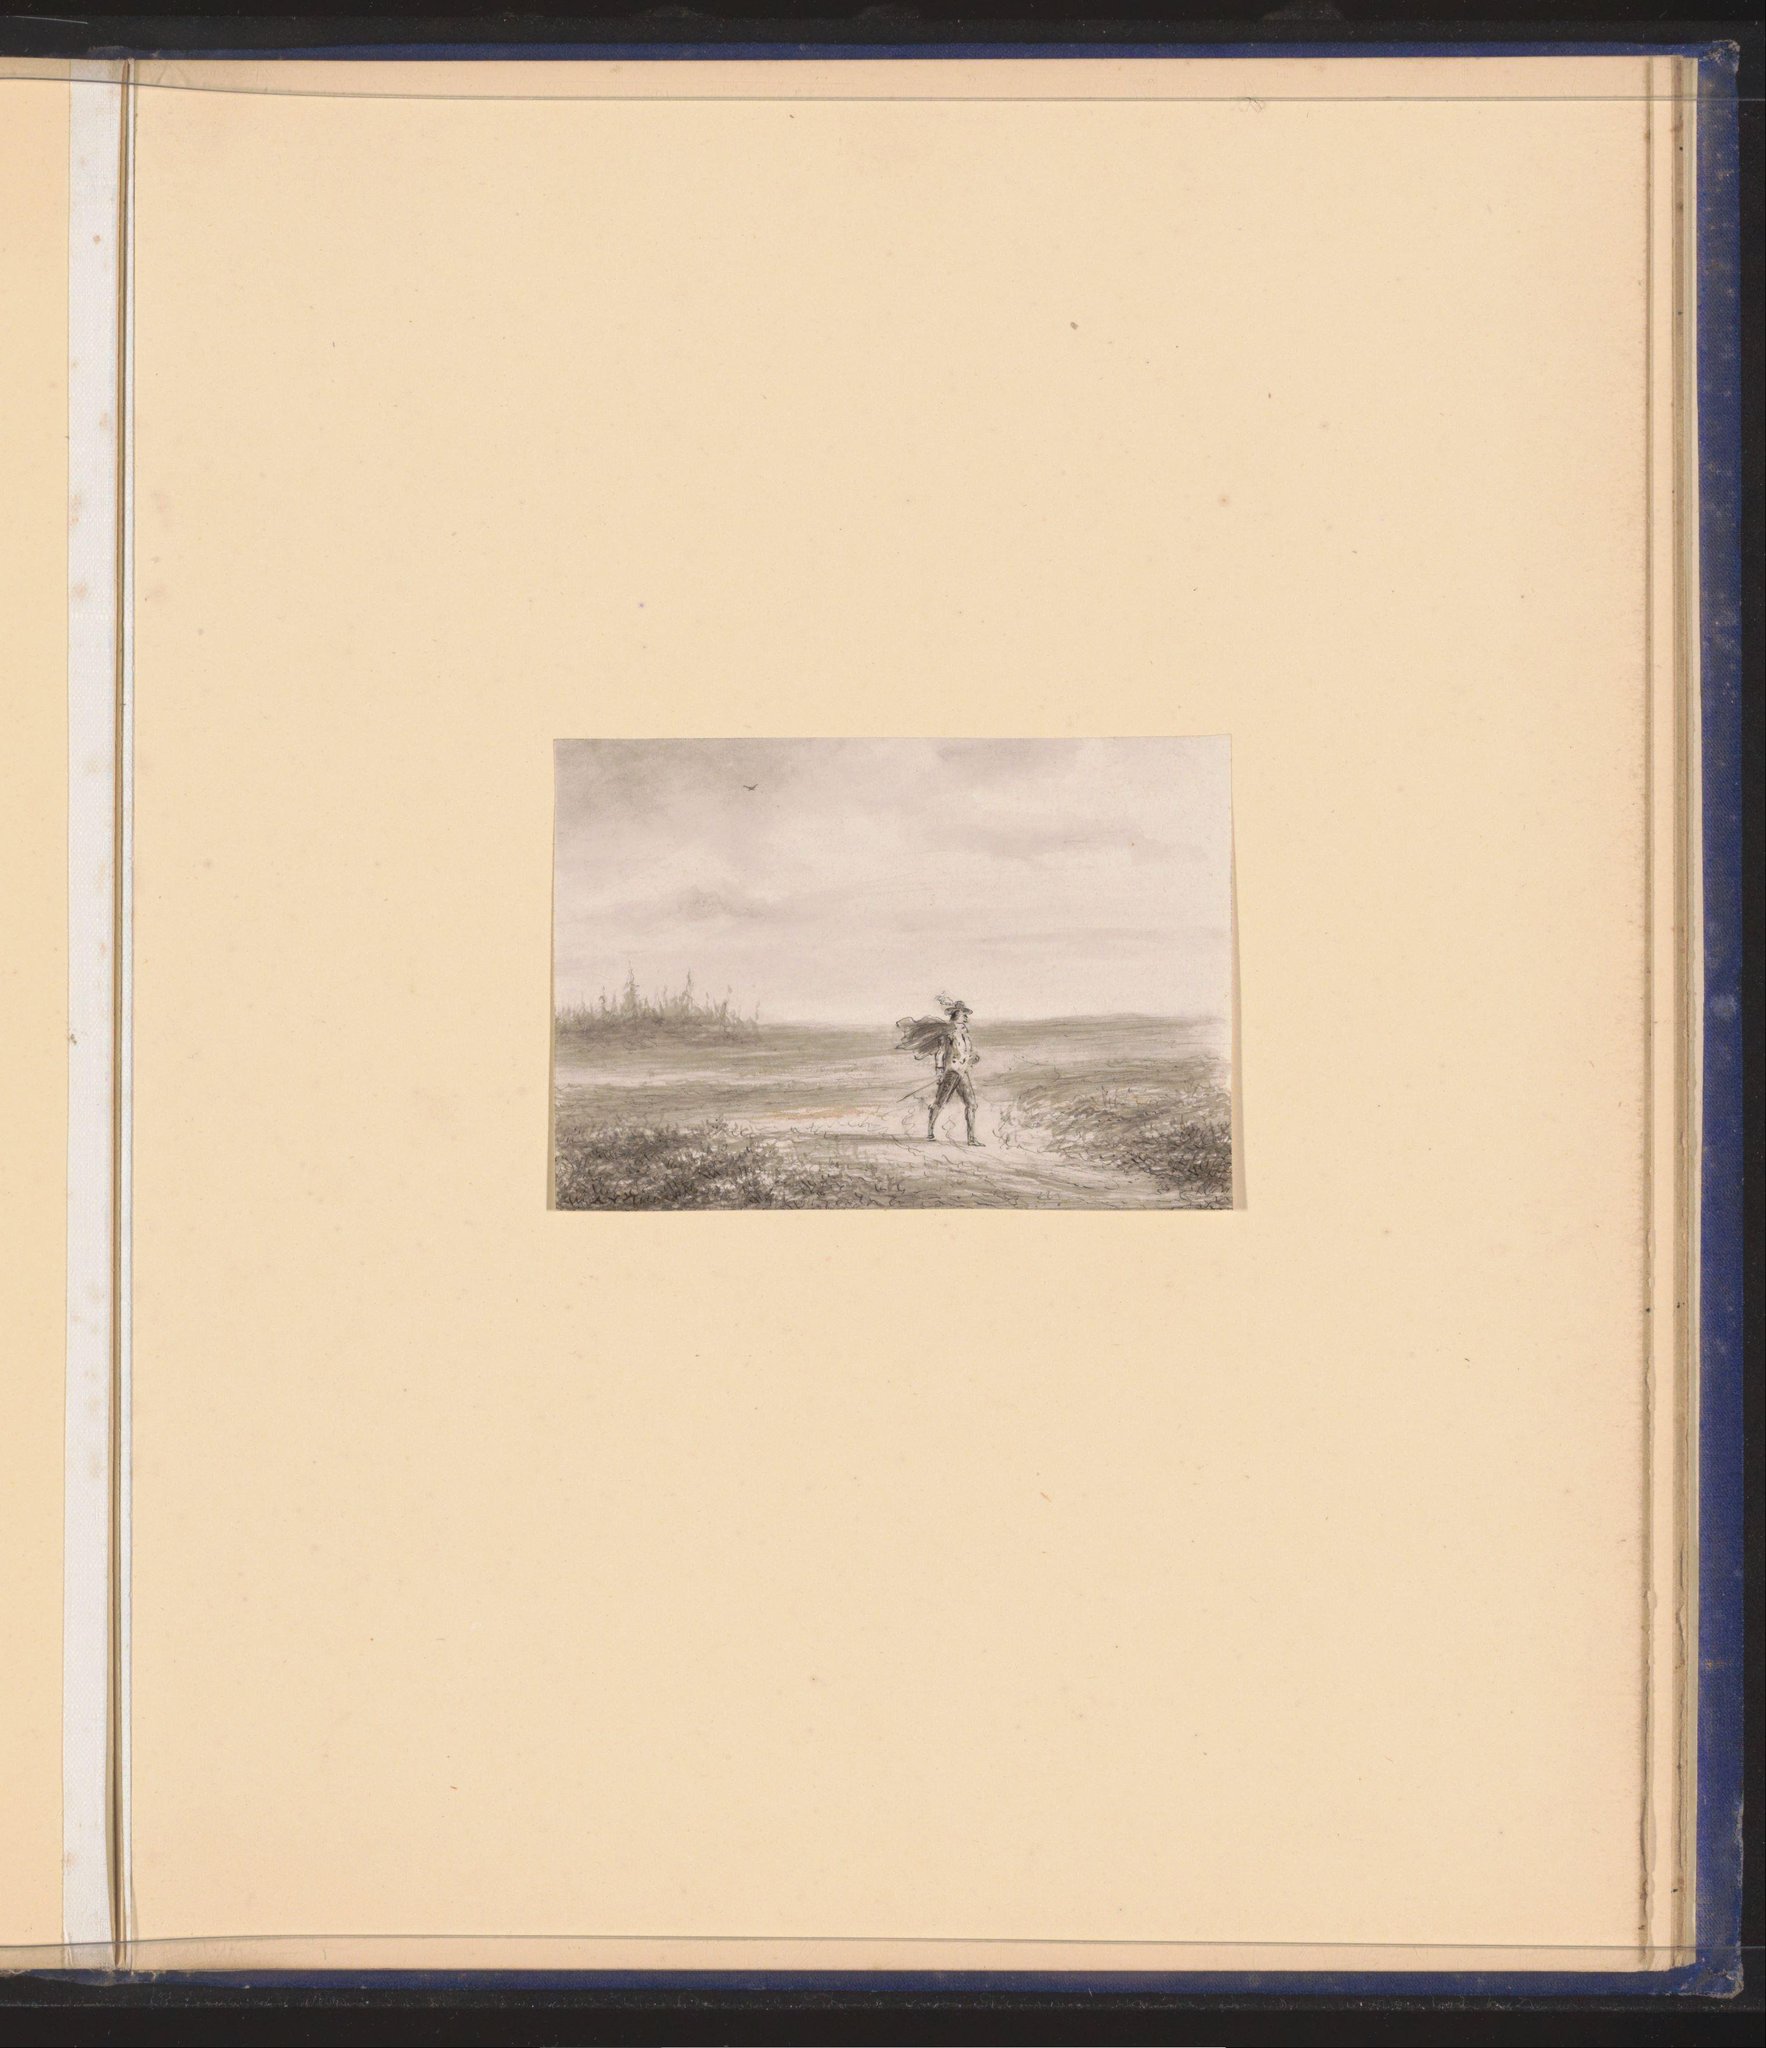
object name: drawing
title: Landschap met een wandelaar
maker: alexander ver huell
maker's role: draughtsman, print maker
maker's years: 1822-1897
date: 1882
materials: ink, paper, pencil, watercolor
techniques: brush, pen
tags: 'en route', traveller under way, landscapes (+ landscape with figures, staffage)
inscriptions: signature: ‘AVH’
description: Tekening op blad 21 van een album met 24 ingeplakte schetsen.